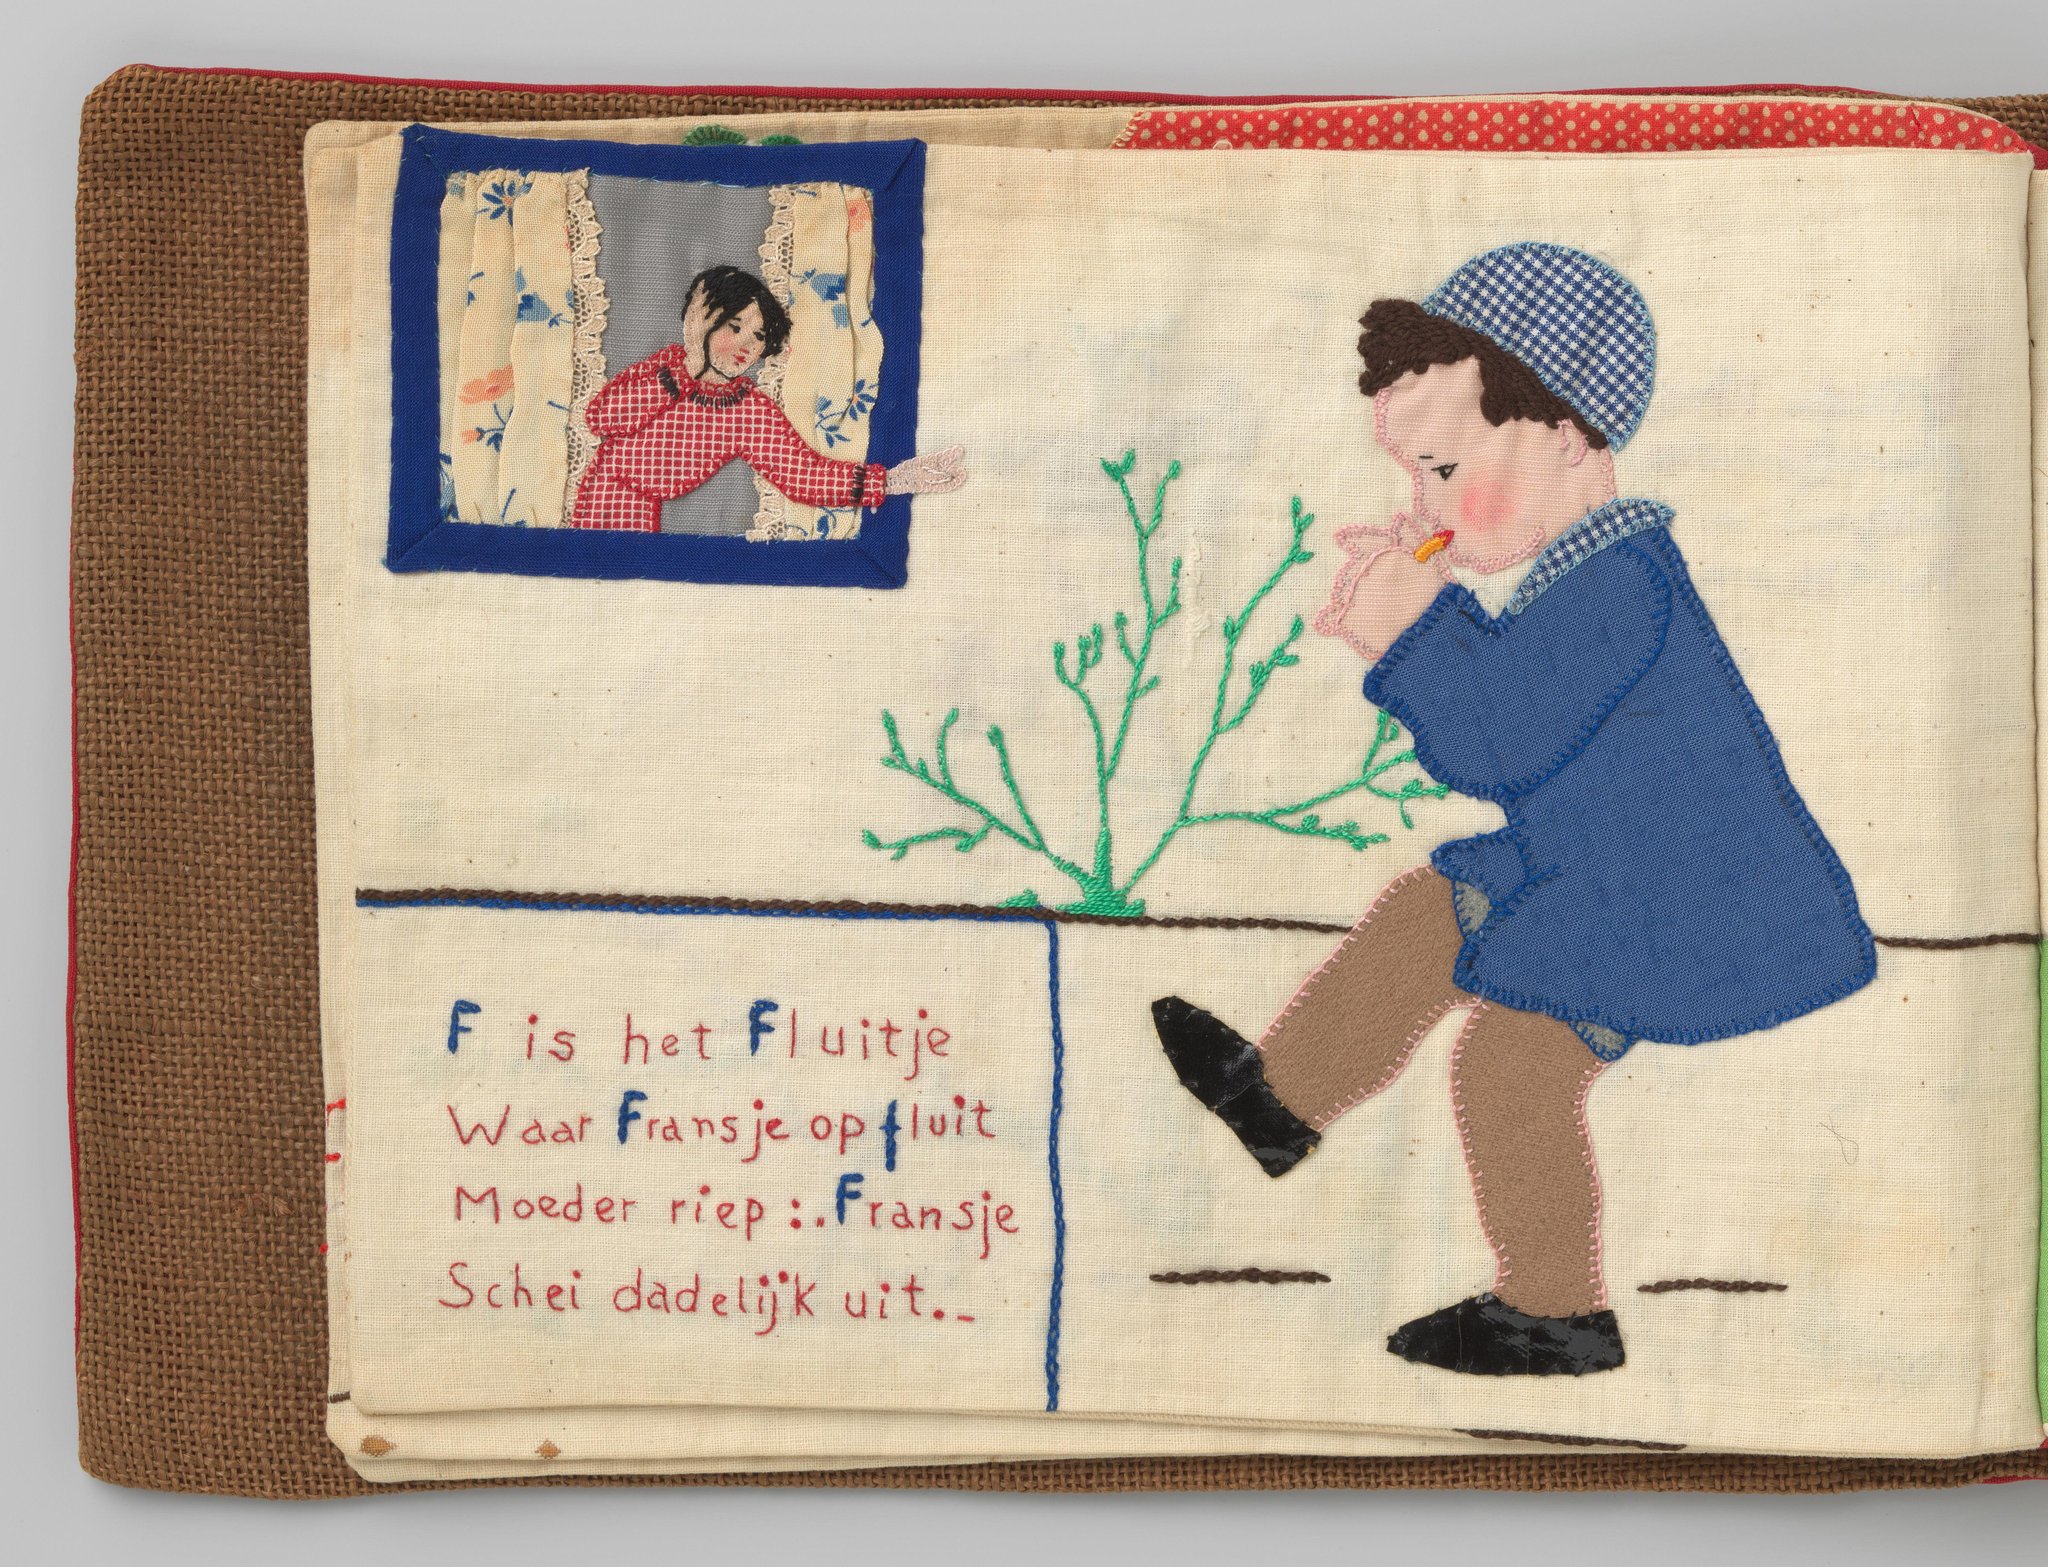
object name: blad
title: F is het Fluitje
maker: miesje geertruida maria petronella aalbersberg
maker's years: 1915-1997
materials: cotton, textile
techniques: appliqué, embroidered, stitch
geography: brastagi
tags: reading, book in which illustrations are essential, letters, alphabet, script, internment camp, nursery school (+ teaching aids), (other forms of) needlework, e.g.: crocheting, knitting, embroidering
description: In het geheim gemaakt kinderboek in textiel vrij naar A is een Aapje van Rie Cramer. Het werd gezamenlijk gemaakt door de vrouwelijke gevangenen van het Japanse interneringskamp Brastagi, een oude plantage in Noord-Sumatra 60 kilometer ten zuiden van Medan aan de weg naar het Toba-meer, tijdens de Tweede Wereldoorlog ter gelegenheid van de vijfde verjaardag van Pem Hagers, de dochter van Miesje Hagers-Aalbersberg die de ontwerptekeningen en sjablonen had gemaakt.